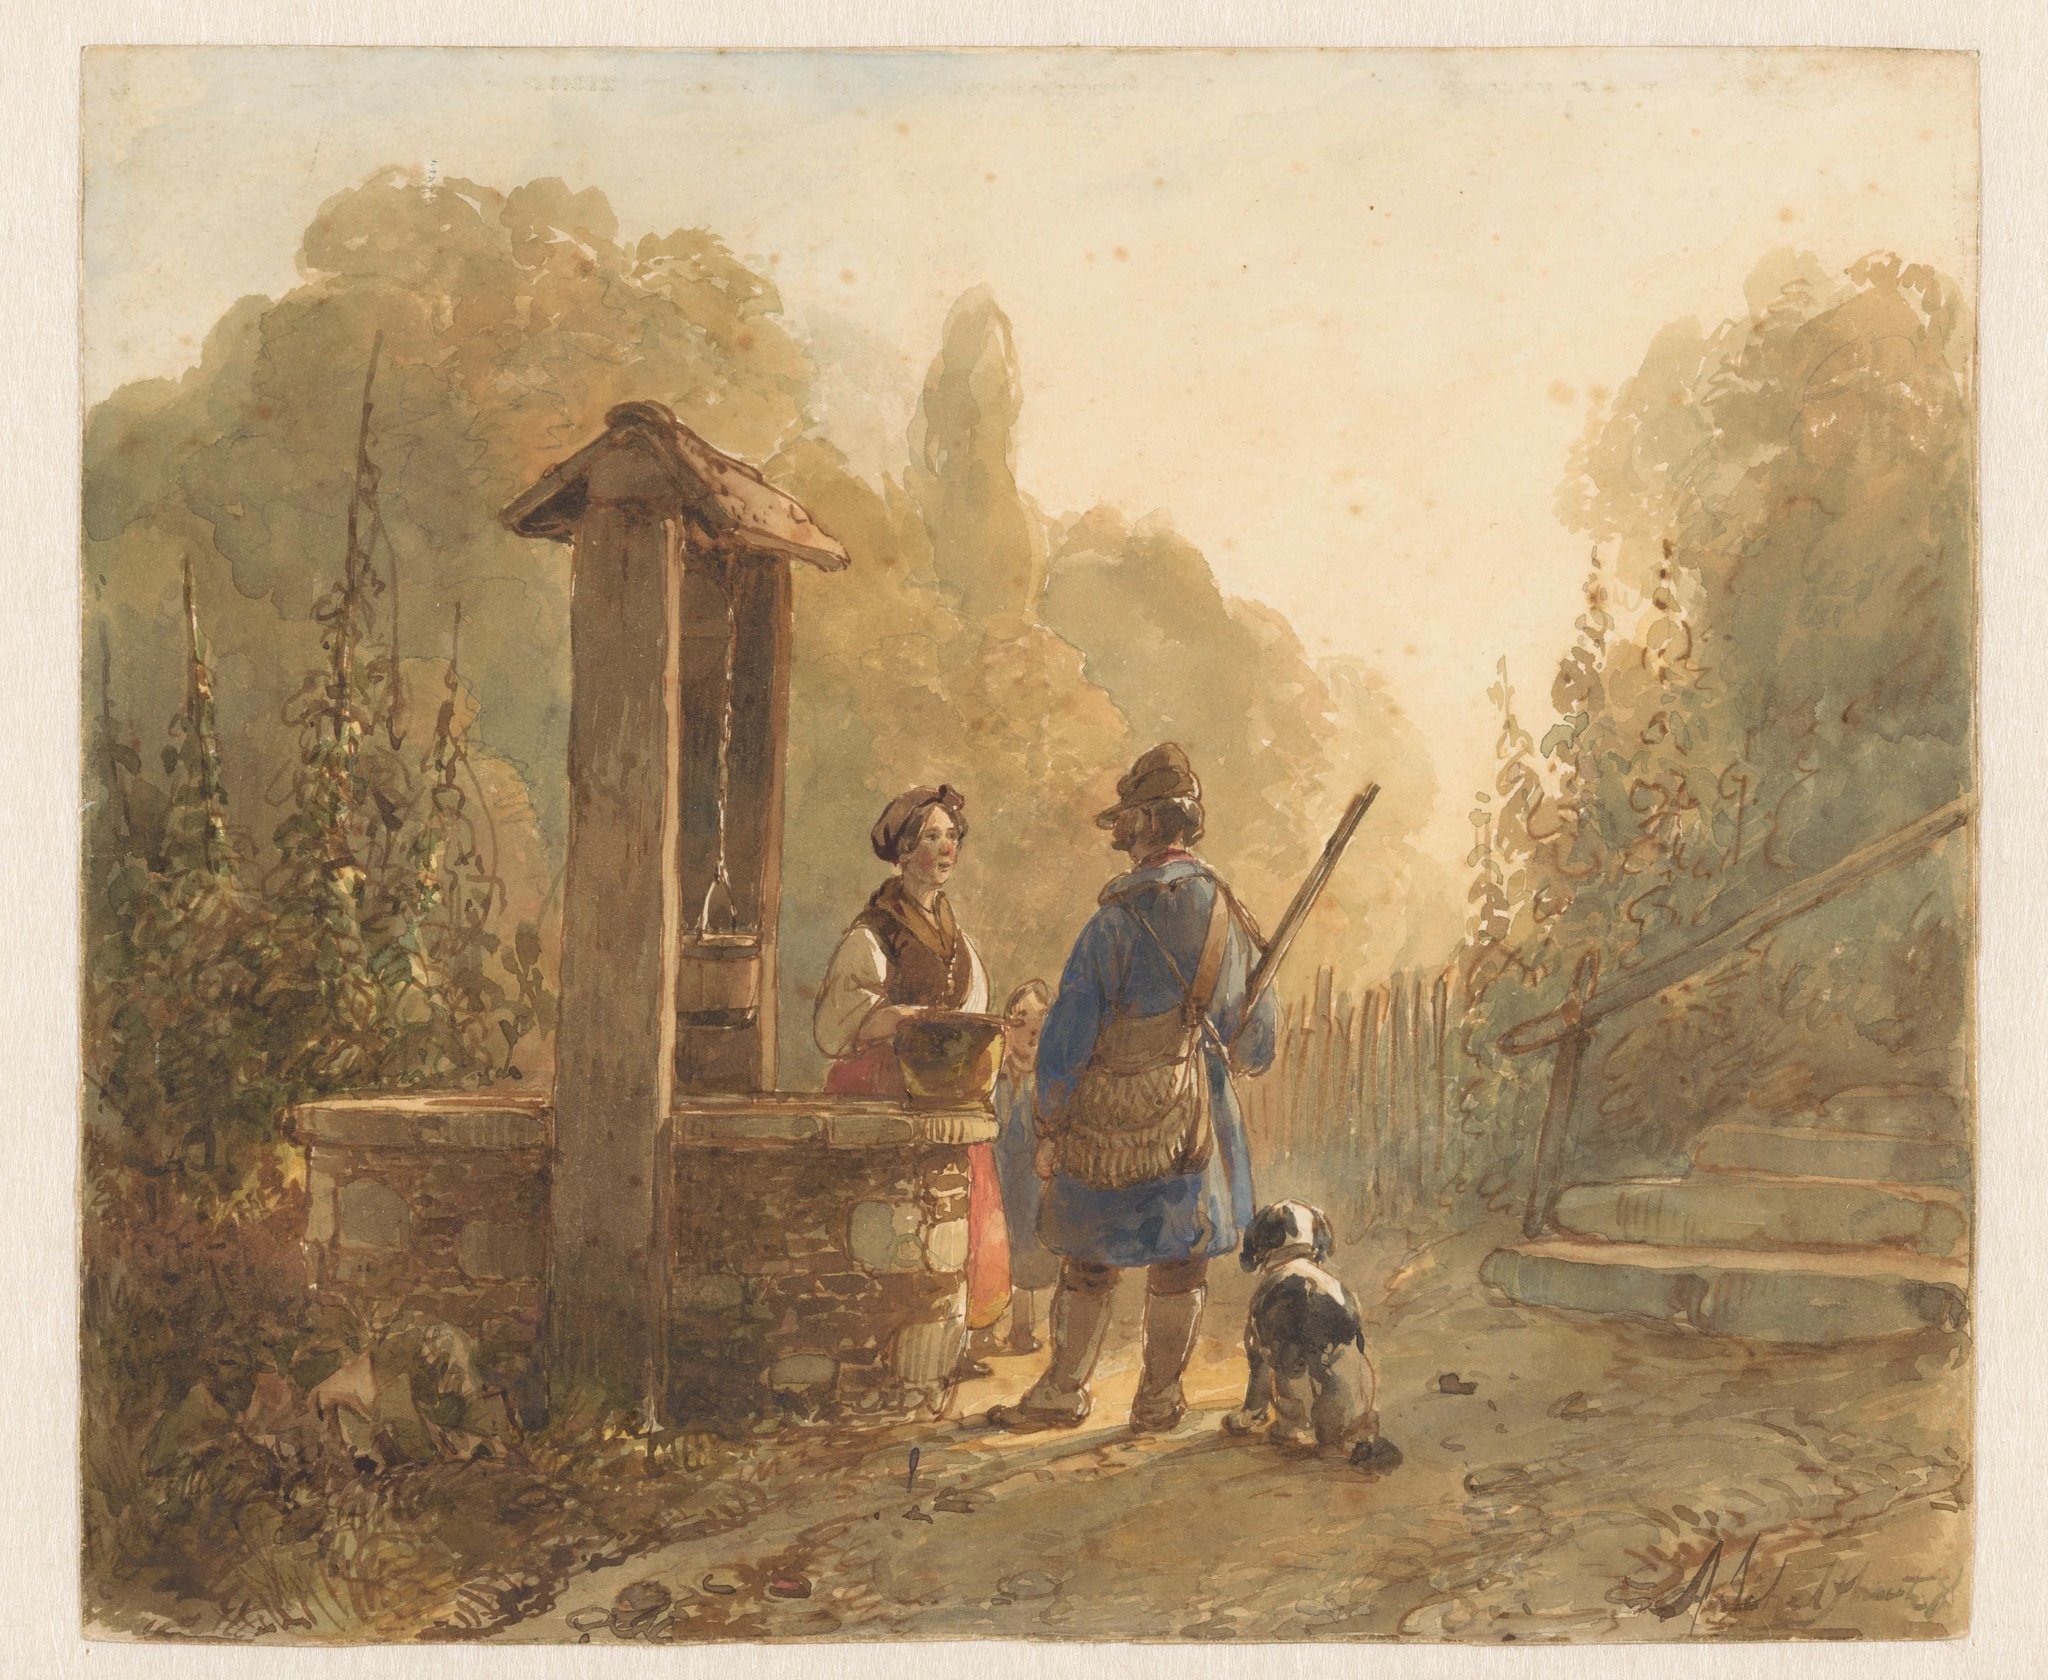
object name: watercolor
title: Jager in gesprek met een boerin bij een waterput, naast hem een hond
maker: andreas schelfhout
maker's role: draughtsman, painter, print maker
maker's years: 1787-1870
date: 1797-1870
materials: ink, paper, pencil, watercolor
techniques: brush, pen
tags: well, hunter, (high) hill, dog